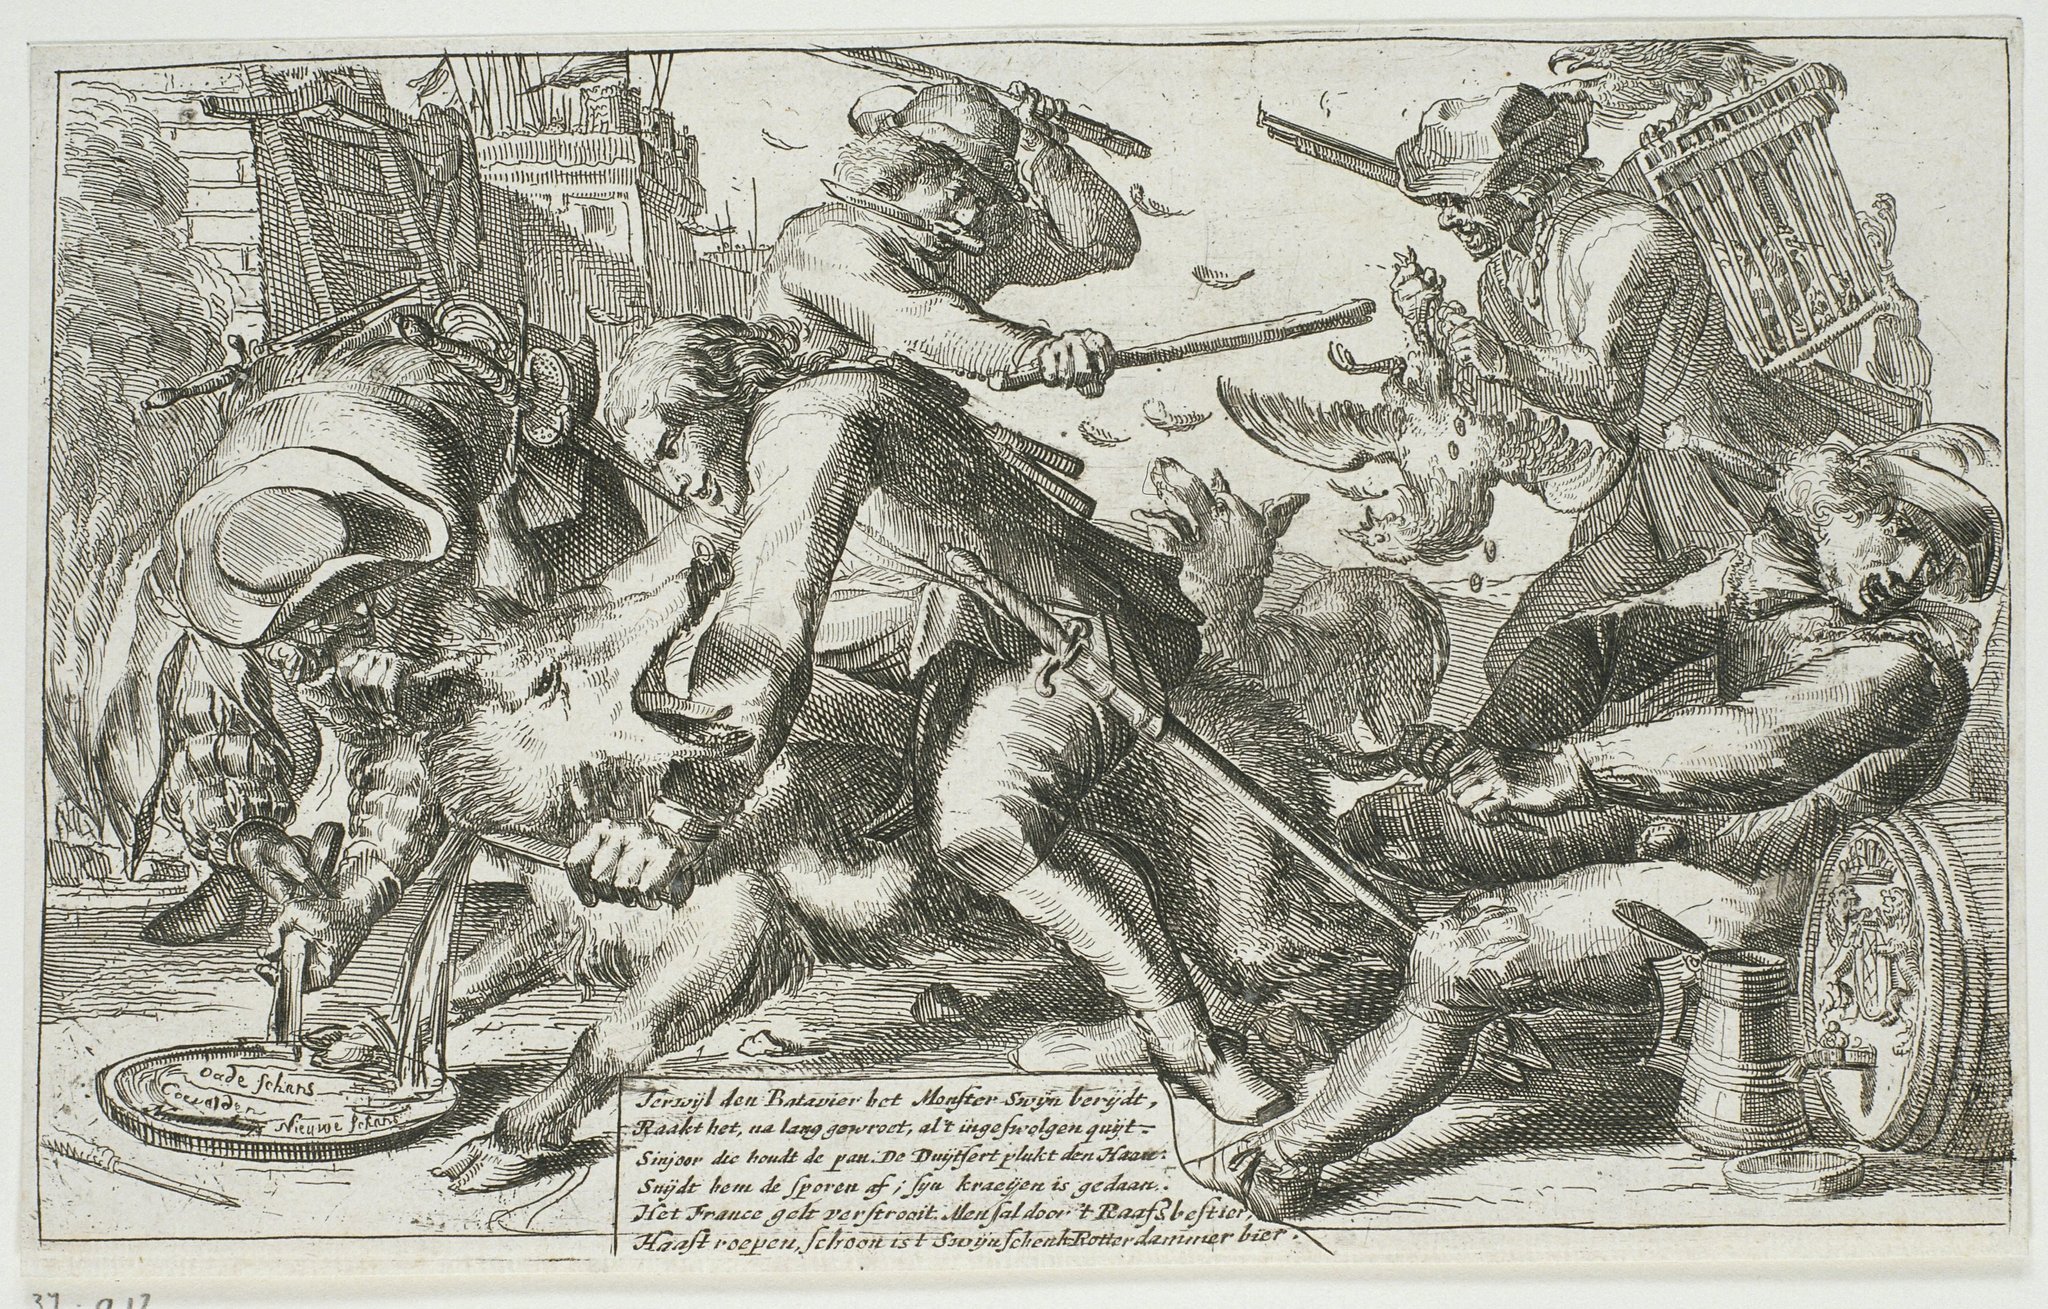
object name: cartoon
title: Spotprenten op Frankrijk, Münster en Keulen na het sluiten van de vrede met Engeland in 1674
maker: romeyn de hooghe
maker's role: draughtsman, goldsmith, painter, print maker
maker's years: 1645-1708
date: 1674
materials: paper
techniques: etching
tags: maximiliaan hendrik van beieren, rampjaar (disaster year)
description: Spotprent op de Münster (en Keulen) na het sluiten van de vrede tussen de Republiek en Engeland, 1674. Een Hollander snijdt een zwijn (Münster) de keel door. Op de achtergrond vangt en plukt een vogelkoopman (Duitsland) de haan (Frankrijk) en wordt een wolf (Keulen) verjaagd. Middenonder een cartouche met een vers van 6 regels in het Nederlands.